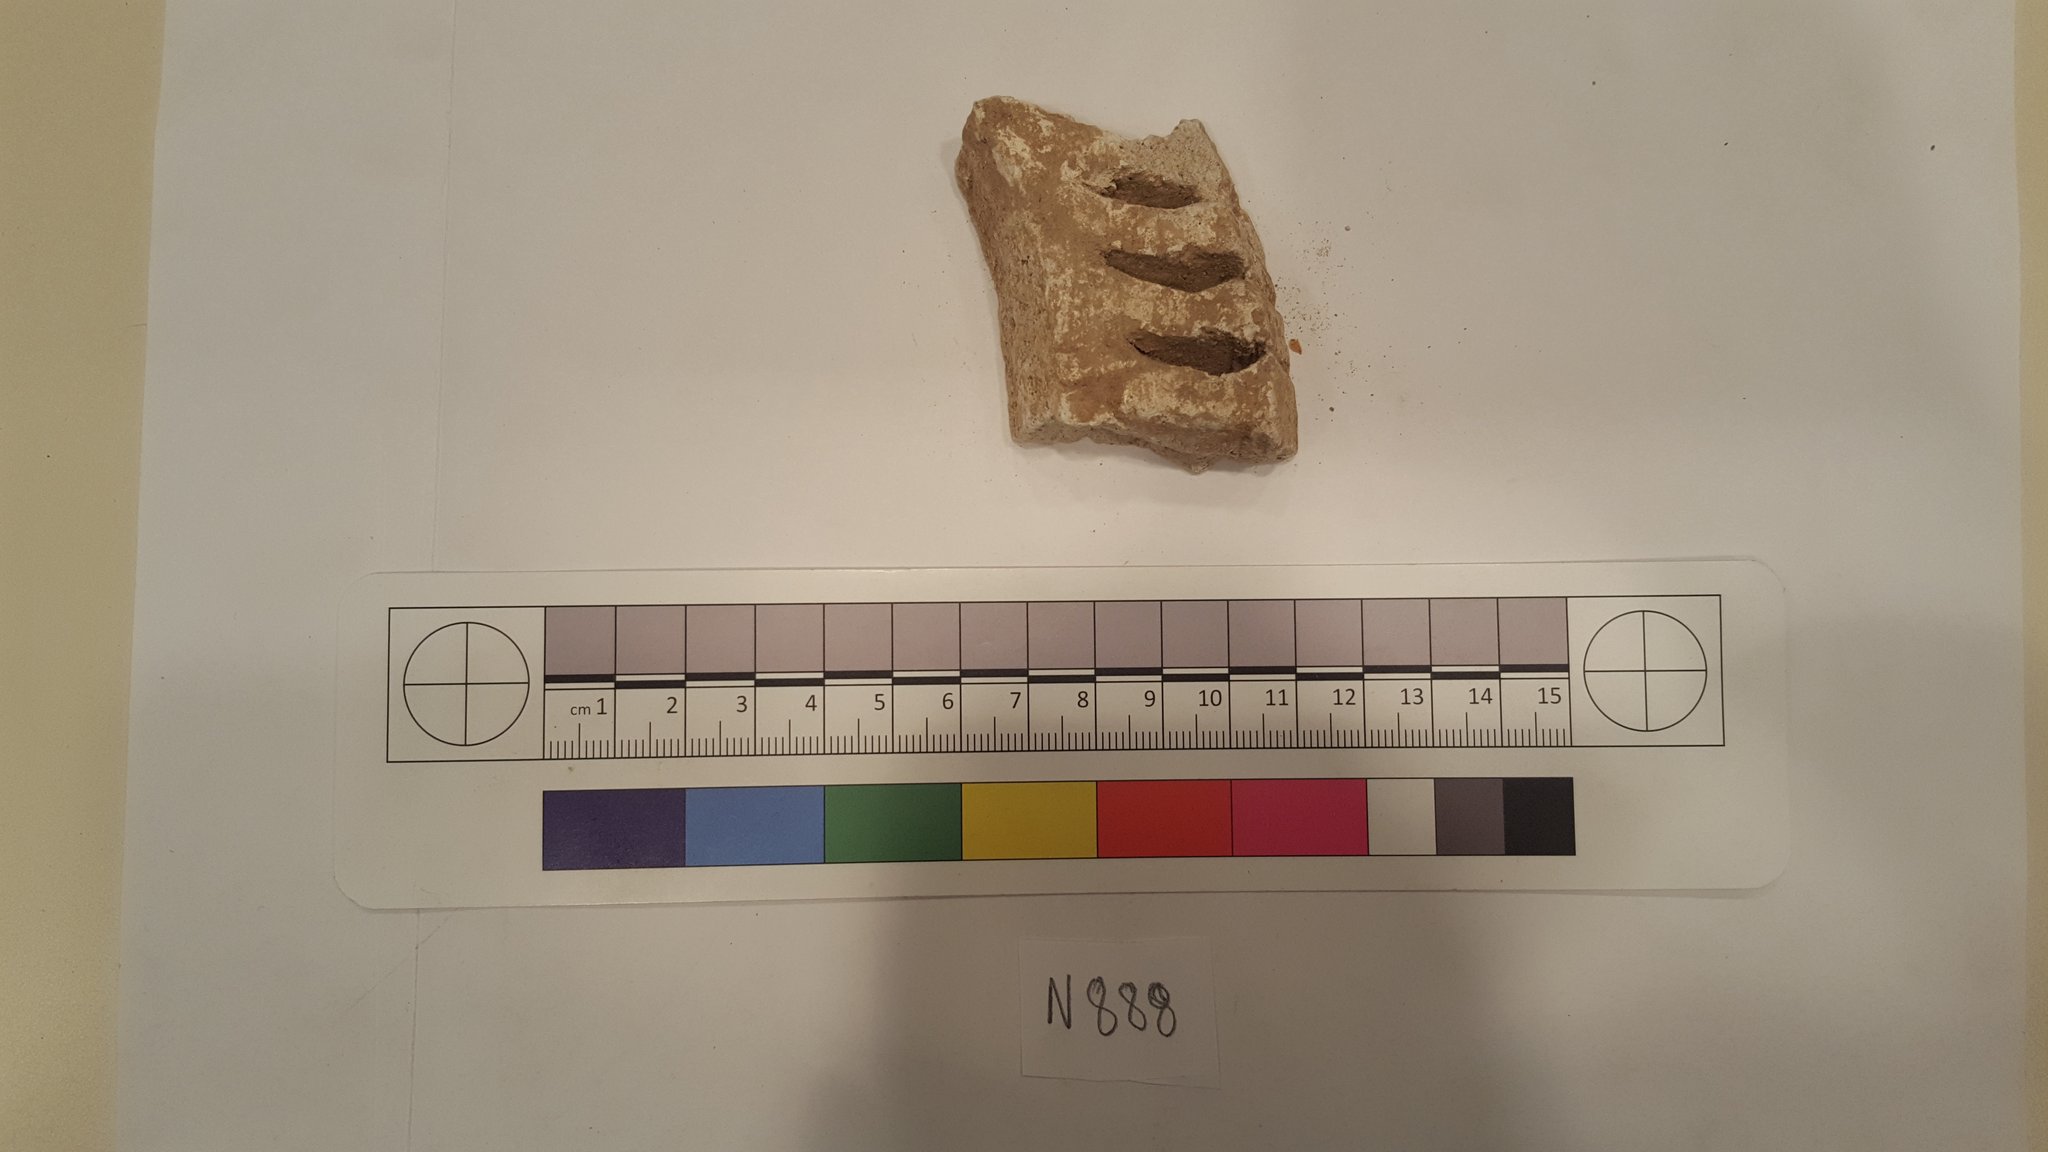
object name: fragment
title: Stucco Fragment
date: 701-1200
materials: plaster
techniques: carving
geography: iran